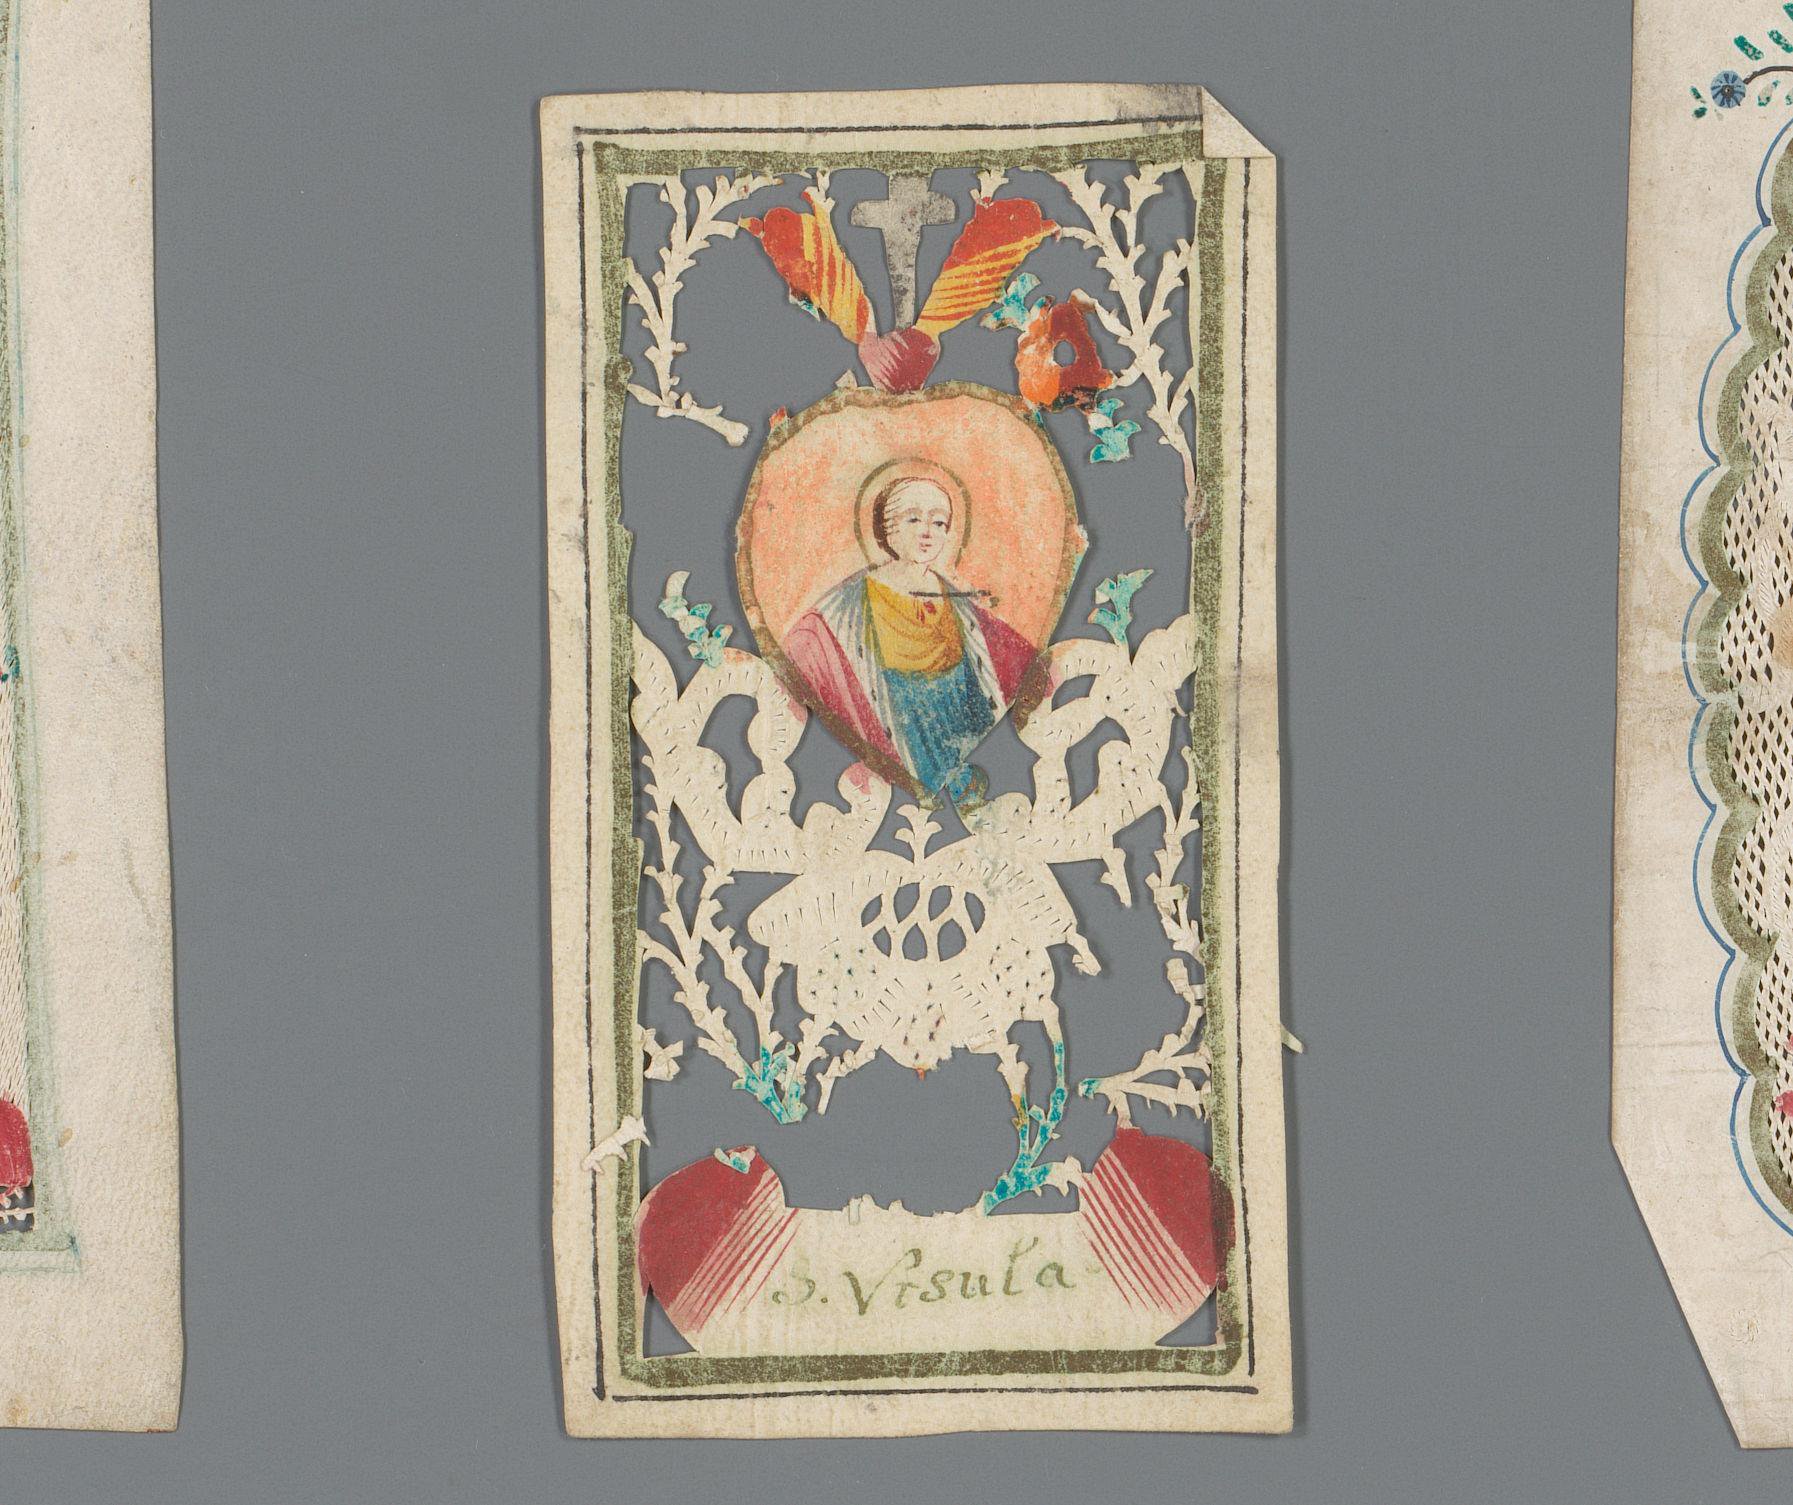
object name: cut paper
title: S. Vrsula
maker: Anonymous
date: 1750-1784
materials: paper, watercolor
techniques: cutting, drawing, snipping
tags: the virgin martyr ursula of cologne; possible attributes: arrow, banner with red cross, cloak of ermine, crown, ship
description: De heilige Ursula met een pijl in haar hals in een uitgesneden decoratieve omlijsting met bloemen, krullen en ranken. Beneden een cartouche met de naam van de heilige.